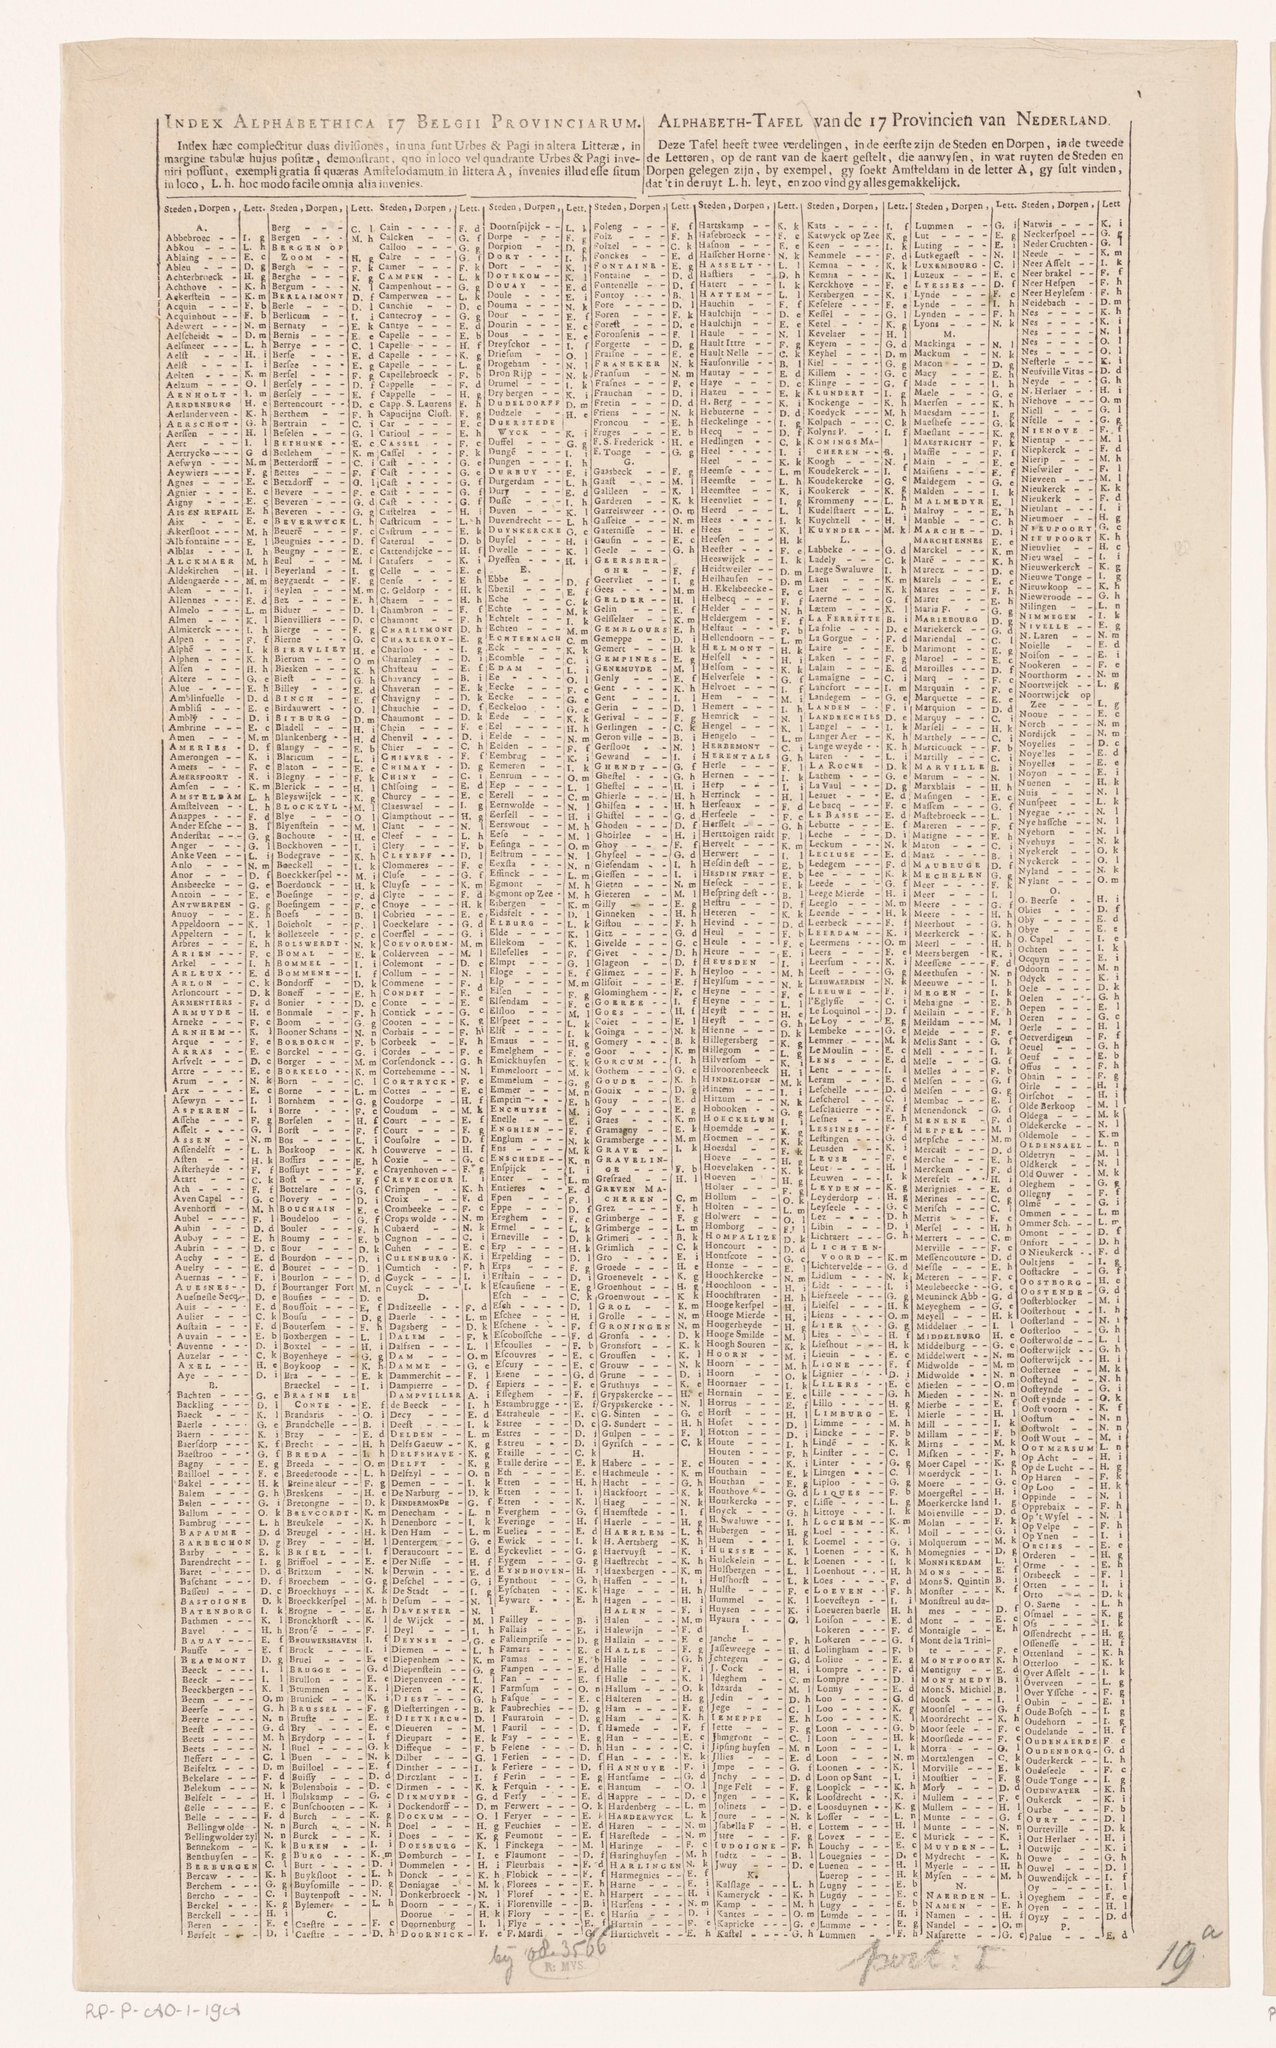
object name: print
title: Index alphabethica 17 Belgii Provinciarum / Alphabeth-tafel van de 17 Provincien van Nederland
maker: frederik de wit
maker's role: print maker, printer, publisher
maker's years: 1629-1706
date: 1666-1710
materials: paper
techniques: letterpress printing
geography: amsterdam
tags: low countries, belgium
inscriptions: collector's mark: Lugt 2228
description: Linkerblad van het plaatsregister van alle dorpen en steden die te vinden zijn op de bijhorende kaart. Naast de plaatsnamen staat aangegeven waar de plaatsen met behulp van het zoekrooster op de kaart gevonden kunnen worden. Boven de kaart de titel en een tekst in het Nederlands en het Latijn. Eerste deel, van Abbebroec tot Palue.